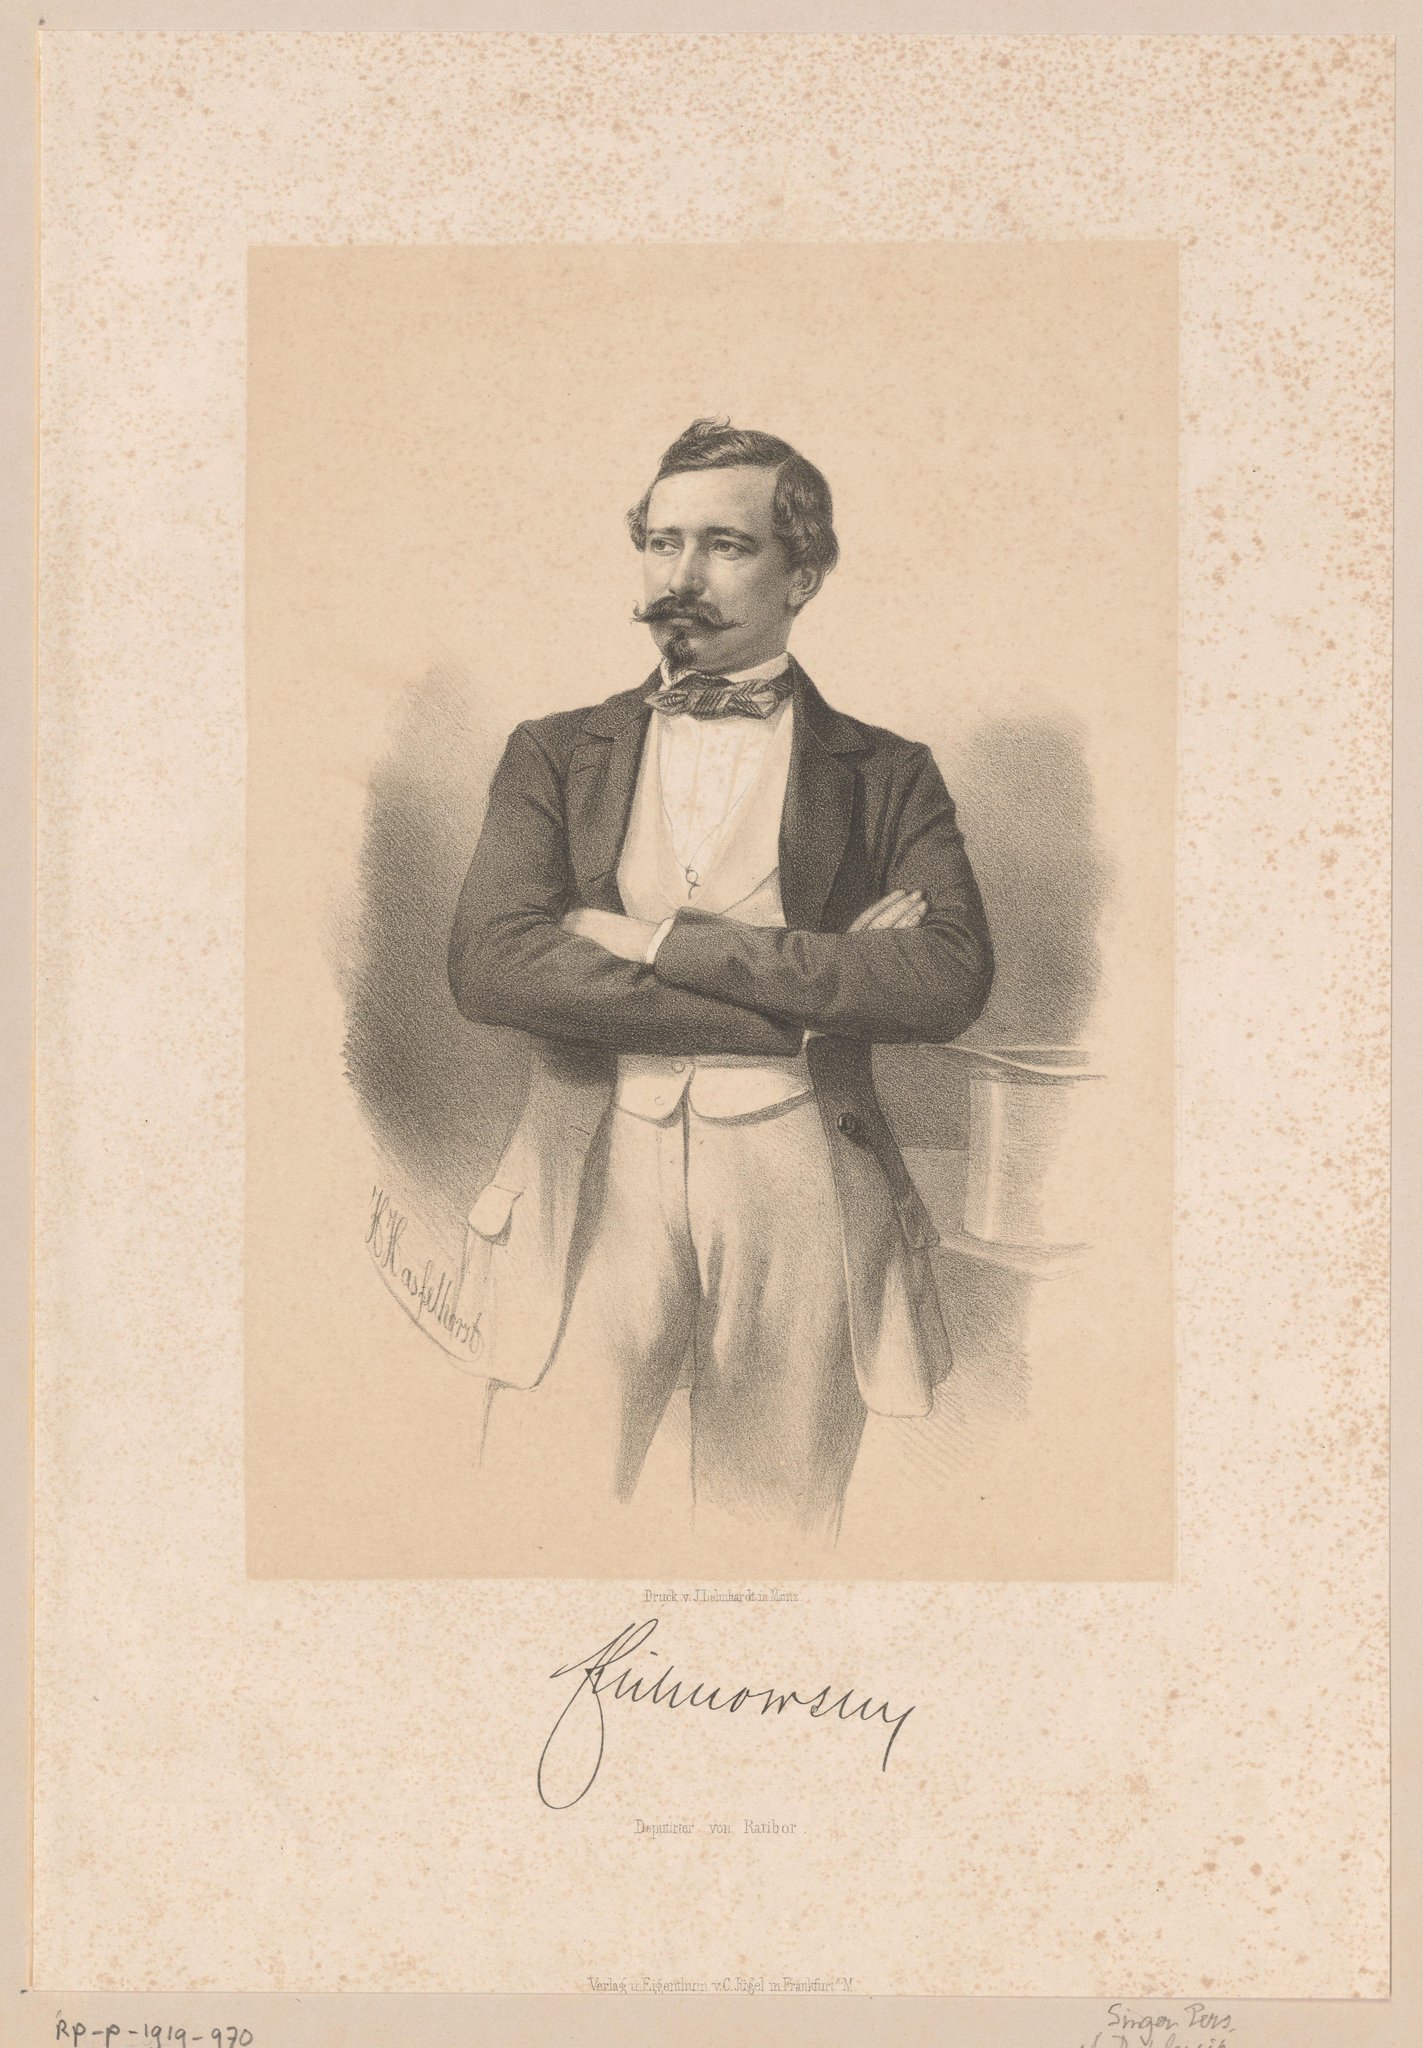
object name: print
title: Portret van Felix Lichnowsky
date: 1845-1862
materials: paper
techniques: lithograph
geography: mainz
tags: commander-in-chief, general, marshal, historical persons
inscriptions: collector's mark: Lugt 2228